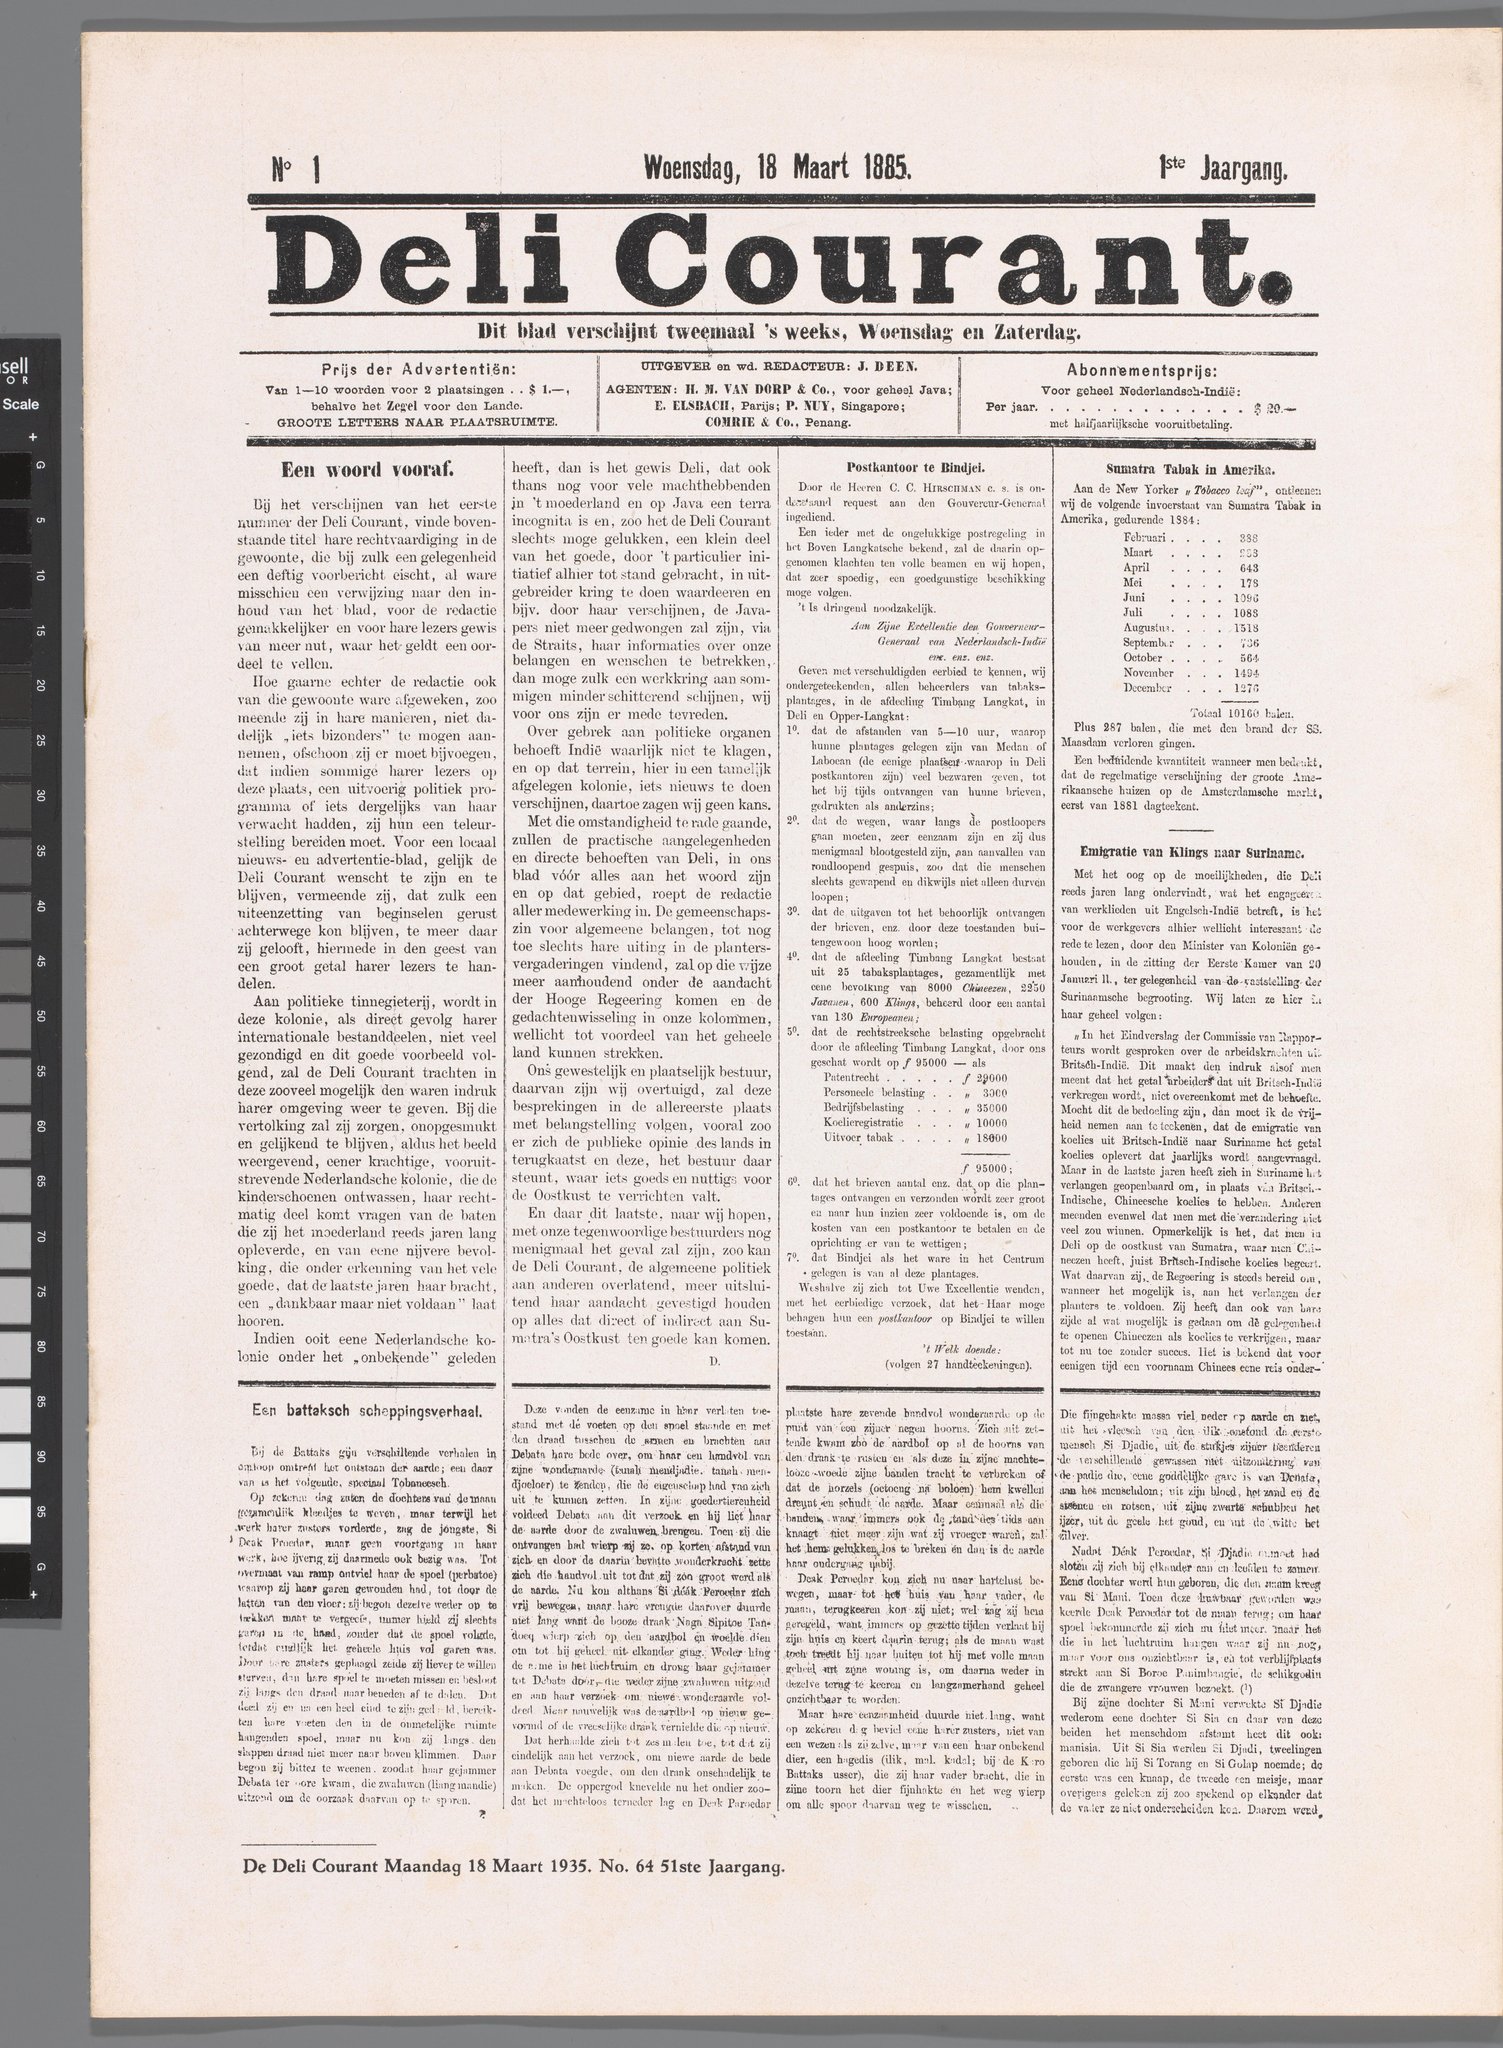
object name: newspaper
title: Herdruk uit 1935 van eerste nummer van de Deli Courant van 18 maart 1885 bij gelegenheid van het 50-jarig bestaan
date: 1935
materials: paper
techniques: printing, stapling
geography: medan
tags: deli courant, deli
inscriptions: : ‘DRUKKERIJ . UITGEVERIJ . BOEKHANDEL . N.V. DE DELI COURANT’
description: Herdruk van eerste nummer van de Deli Courant van 18 maart 1885 bij gelegenheid van het 50-jarig bestaan in 1935. Krant met vier dubbelgevouwen aan elkaar geniete bladen, genummerd. 16 Pagina's, twee kolommendruk soms met foto's, voorpagina 4 kolommen.